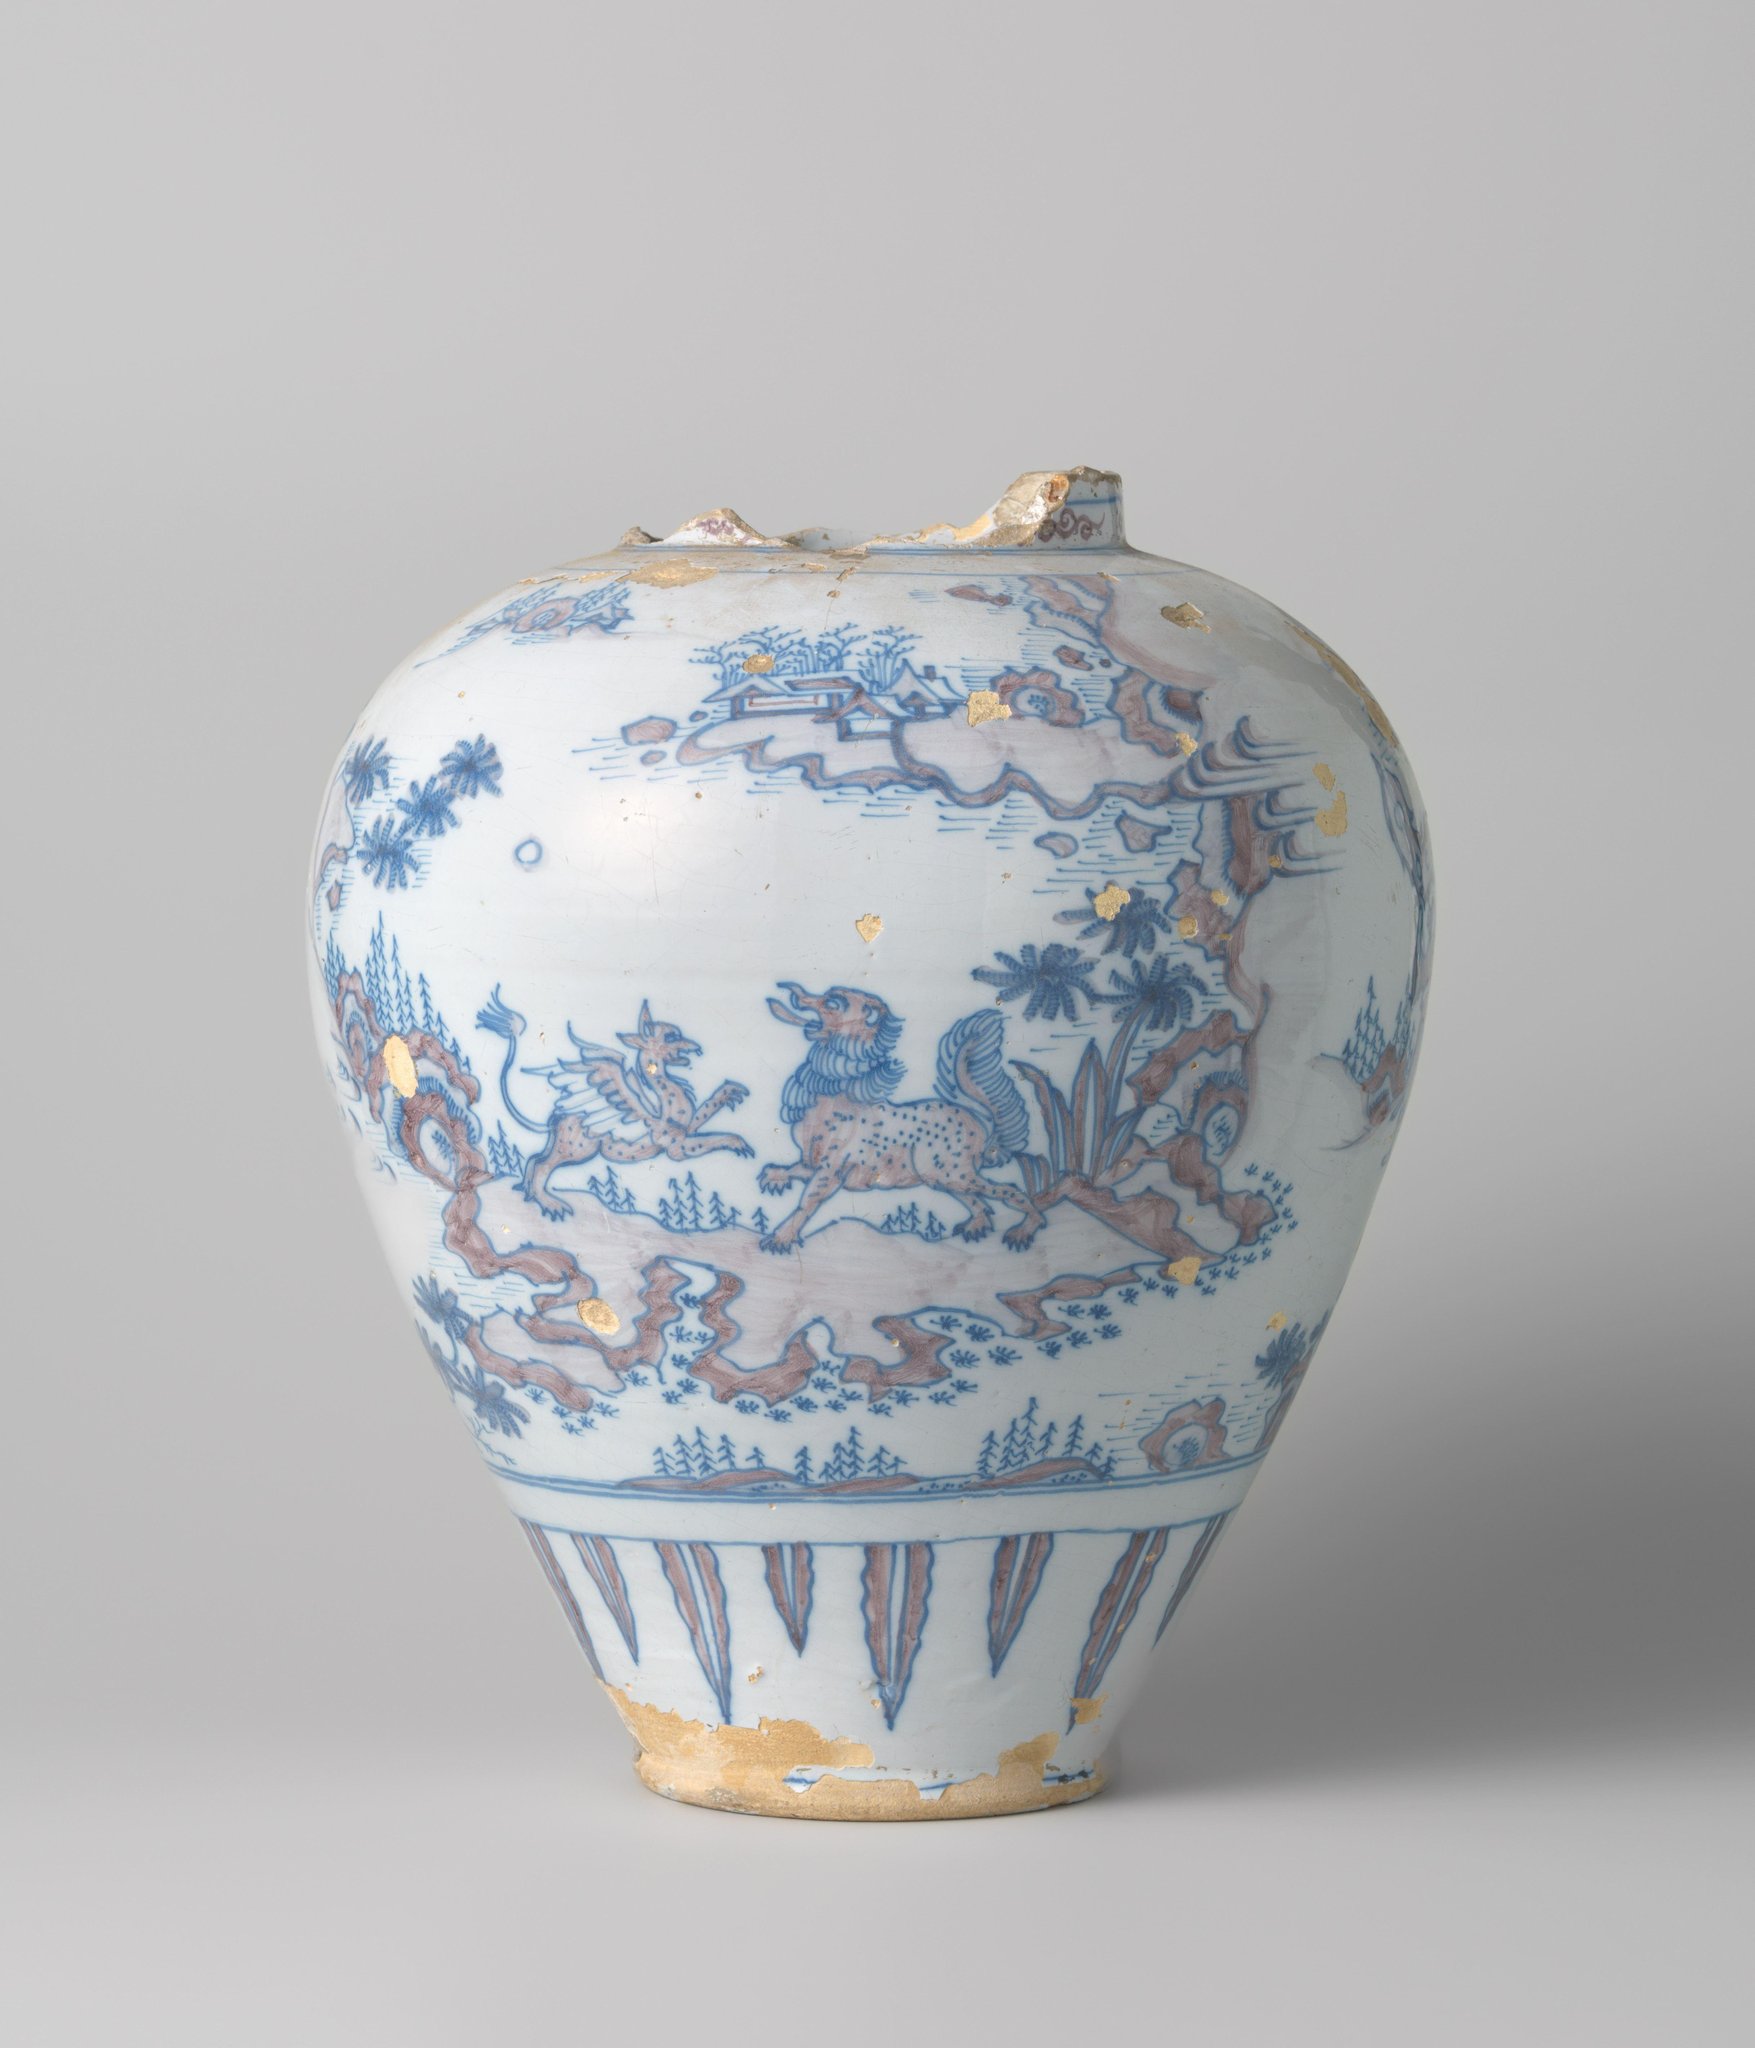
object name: vase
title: Vaas, beschilderd met chinoiserie decoratie in blauw en paars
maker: Anonymous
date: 1660-1690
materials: faience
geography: delft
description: Vaas van faience. Beschilderd in blauw en paars met een chinoiserie decoratie.